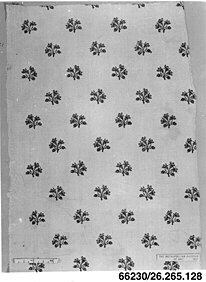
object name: floral print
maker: oberkampf manufactory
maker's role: manufactory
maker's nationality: french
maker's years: 1760-1843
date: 1785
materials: linen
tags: flowers